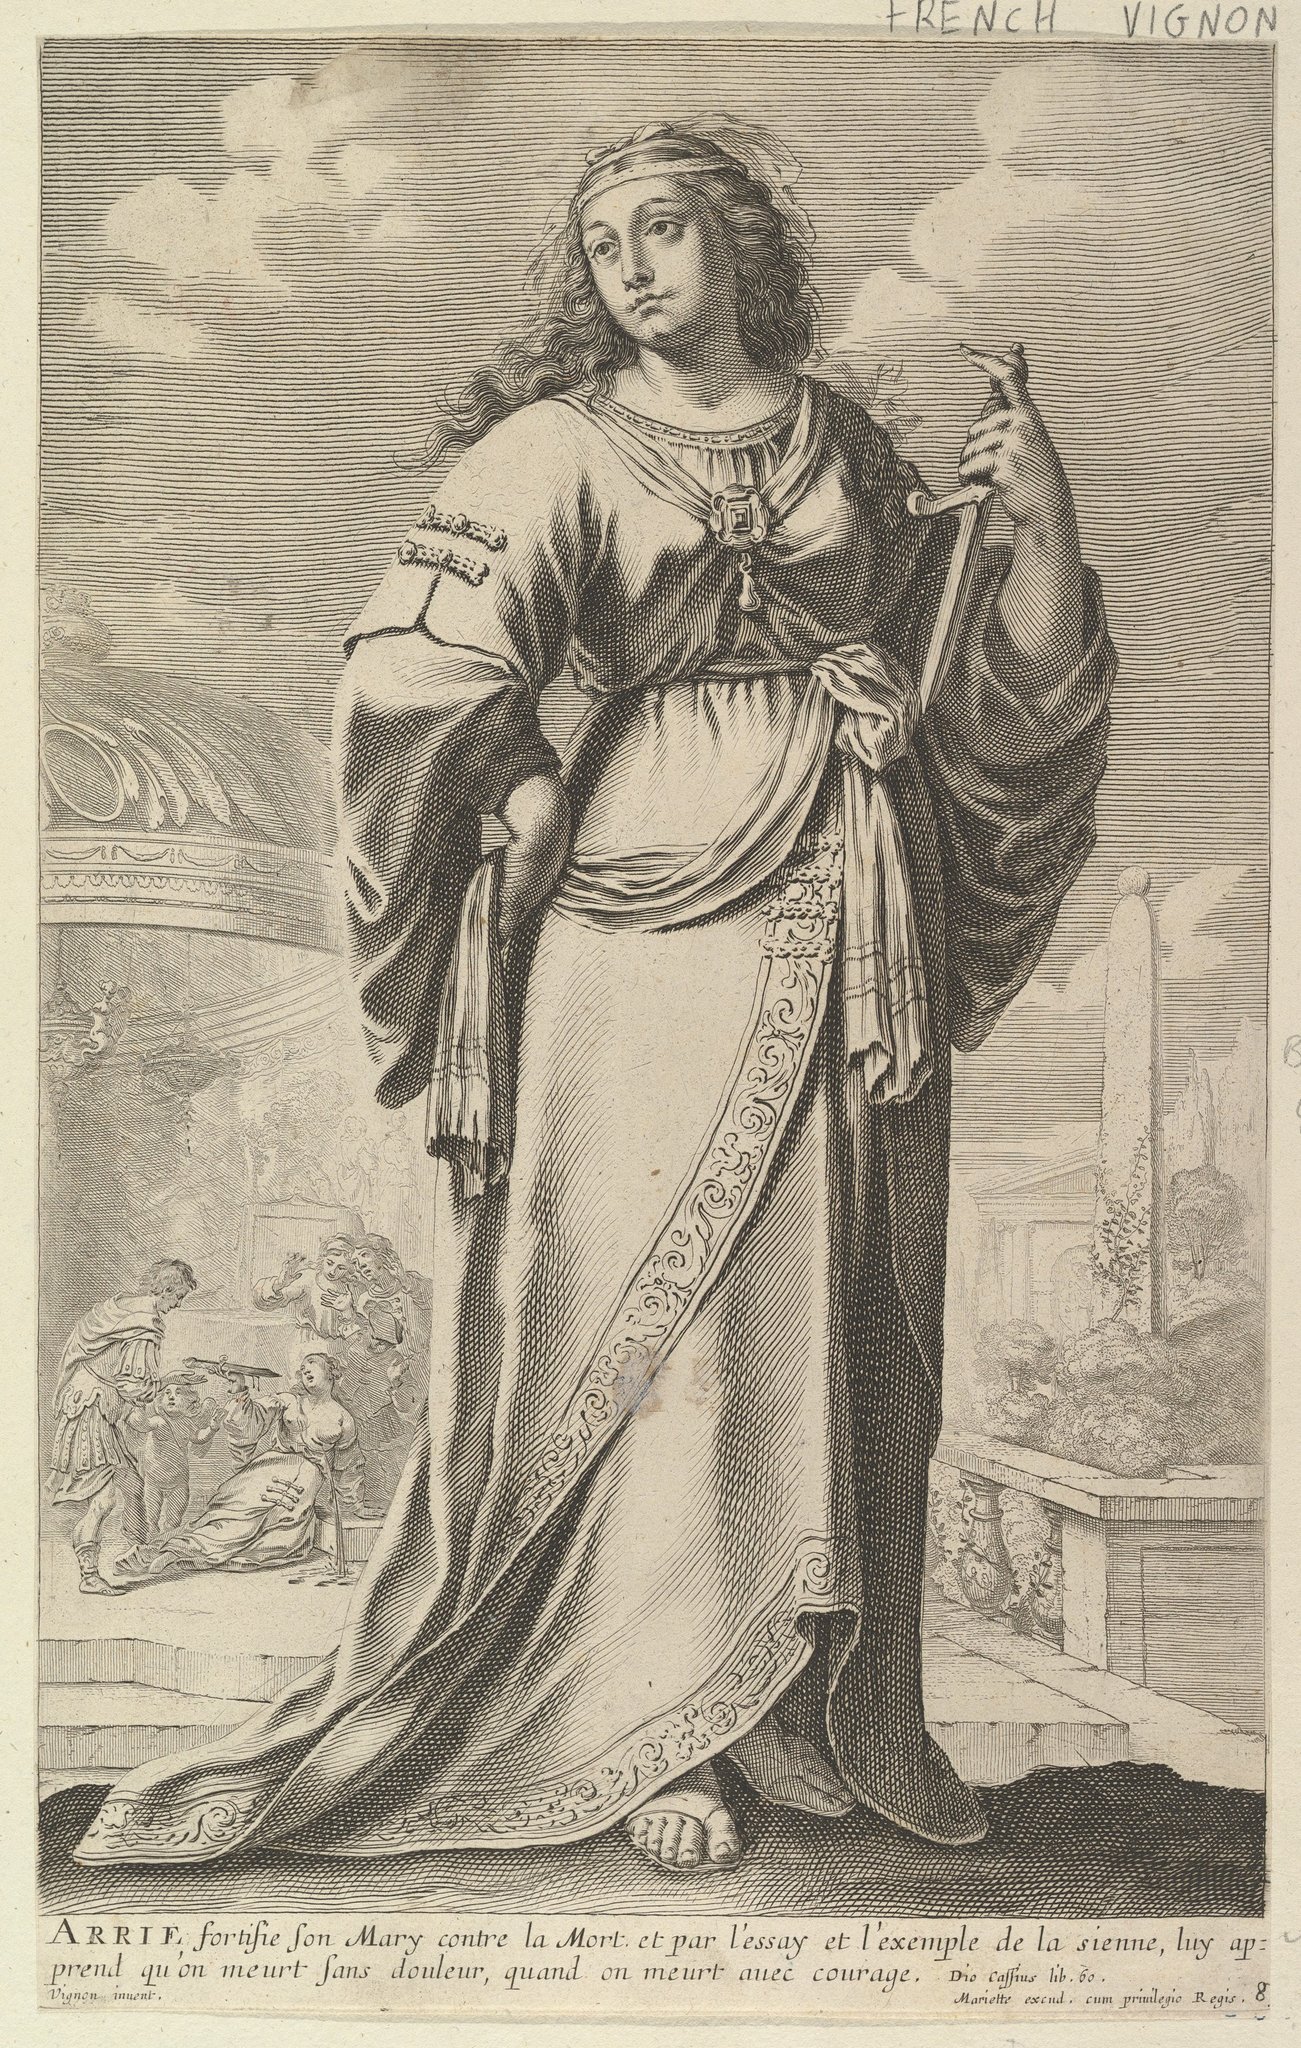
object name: print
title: Arrie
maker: gilles rousselet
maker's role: artist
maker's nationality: french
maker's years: 1614-1686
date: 1647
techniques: engraving, etching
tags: women